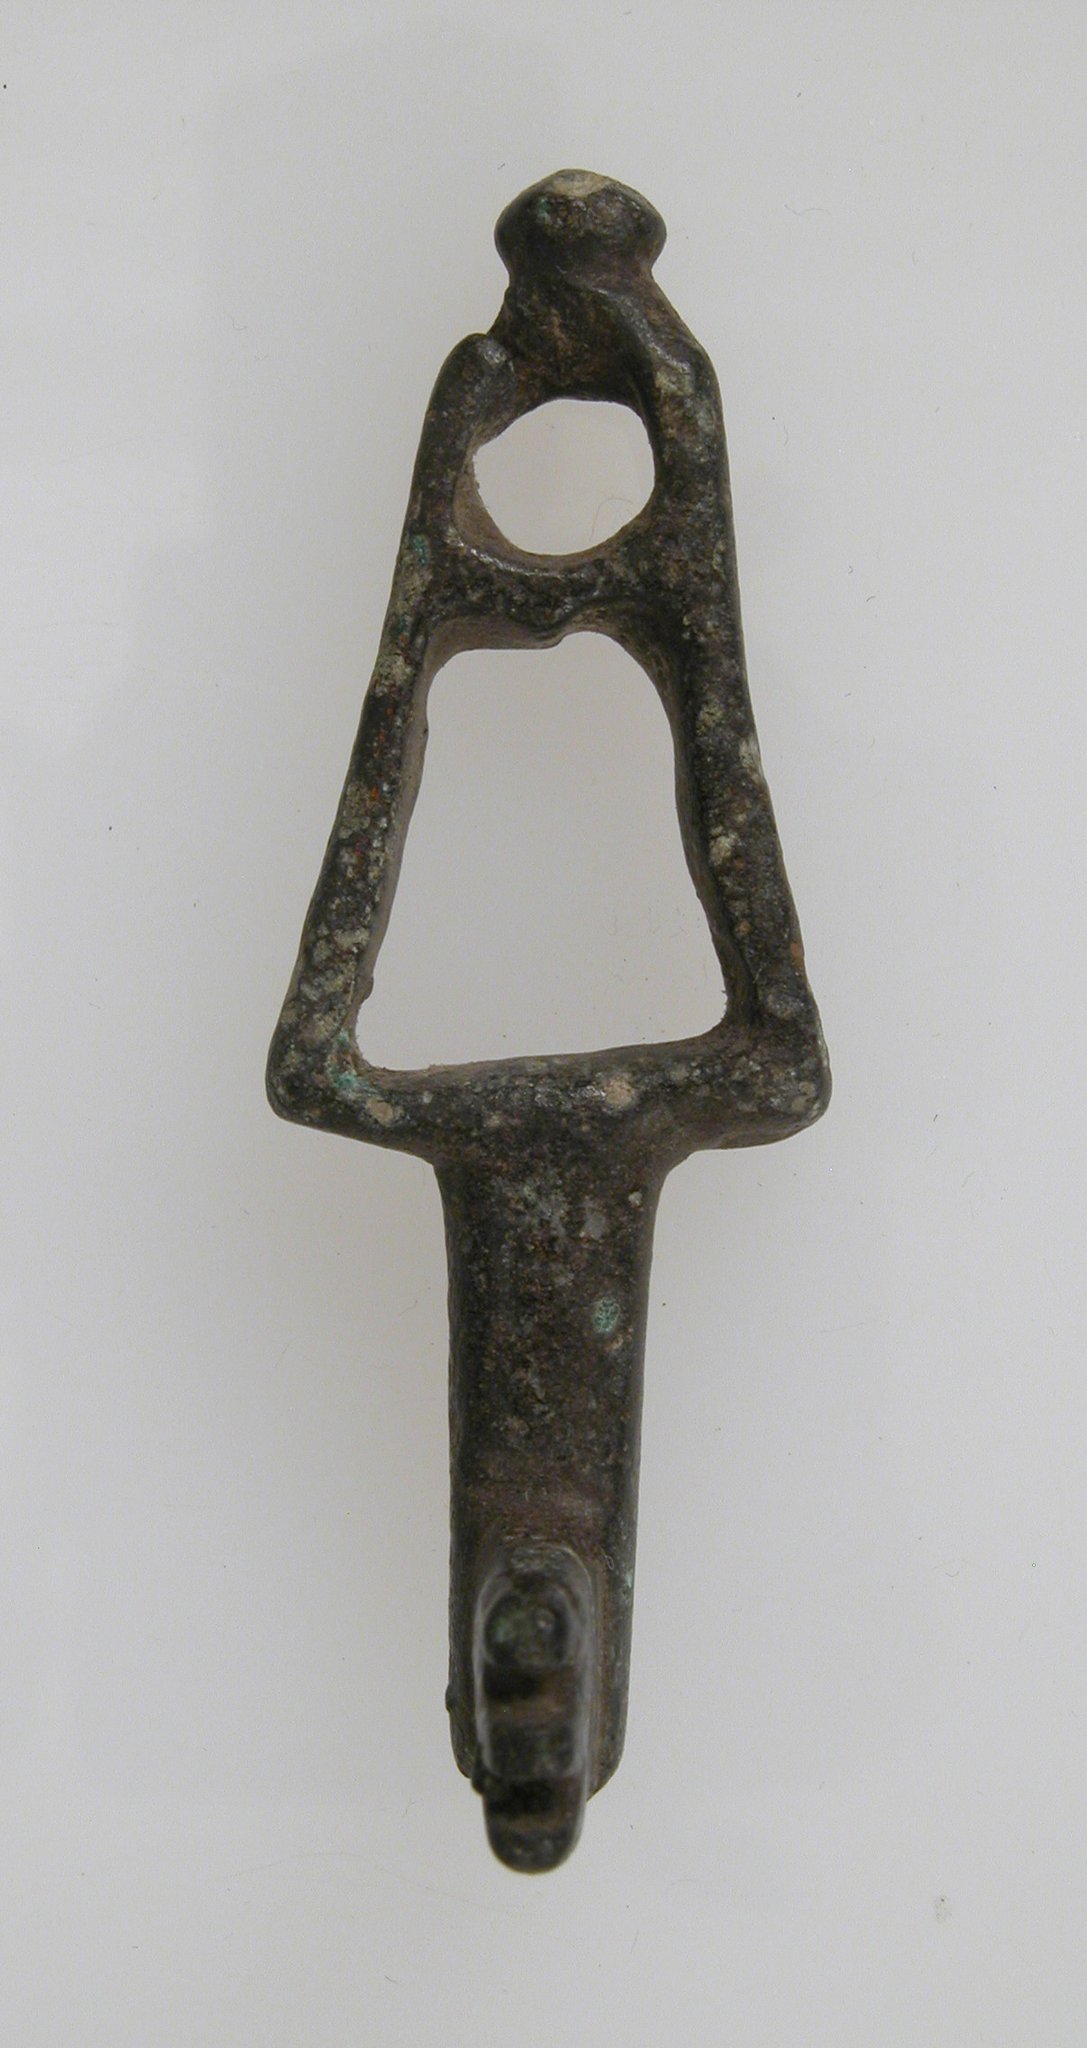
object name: key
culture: roman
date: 1-700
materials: copper alloy